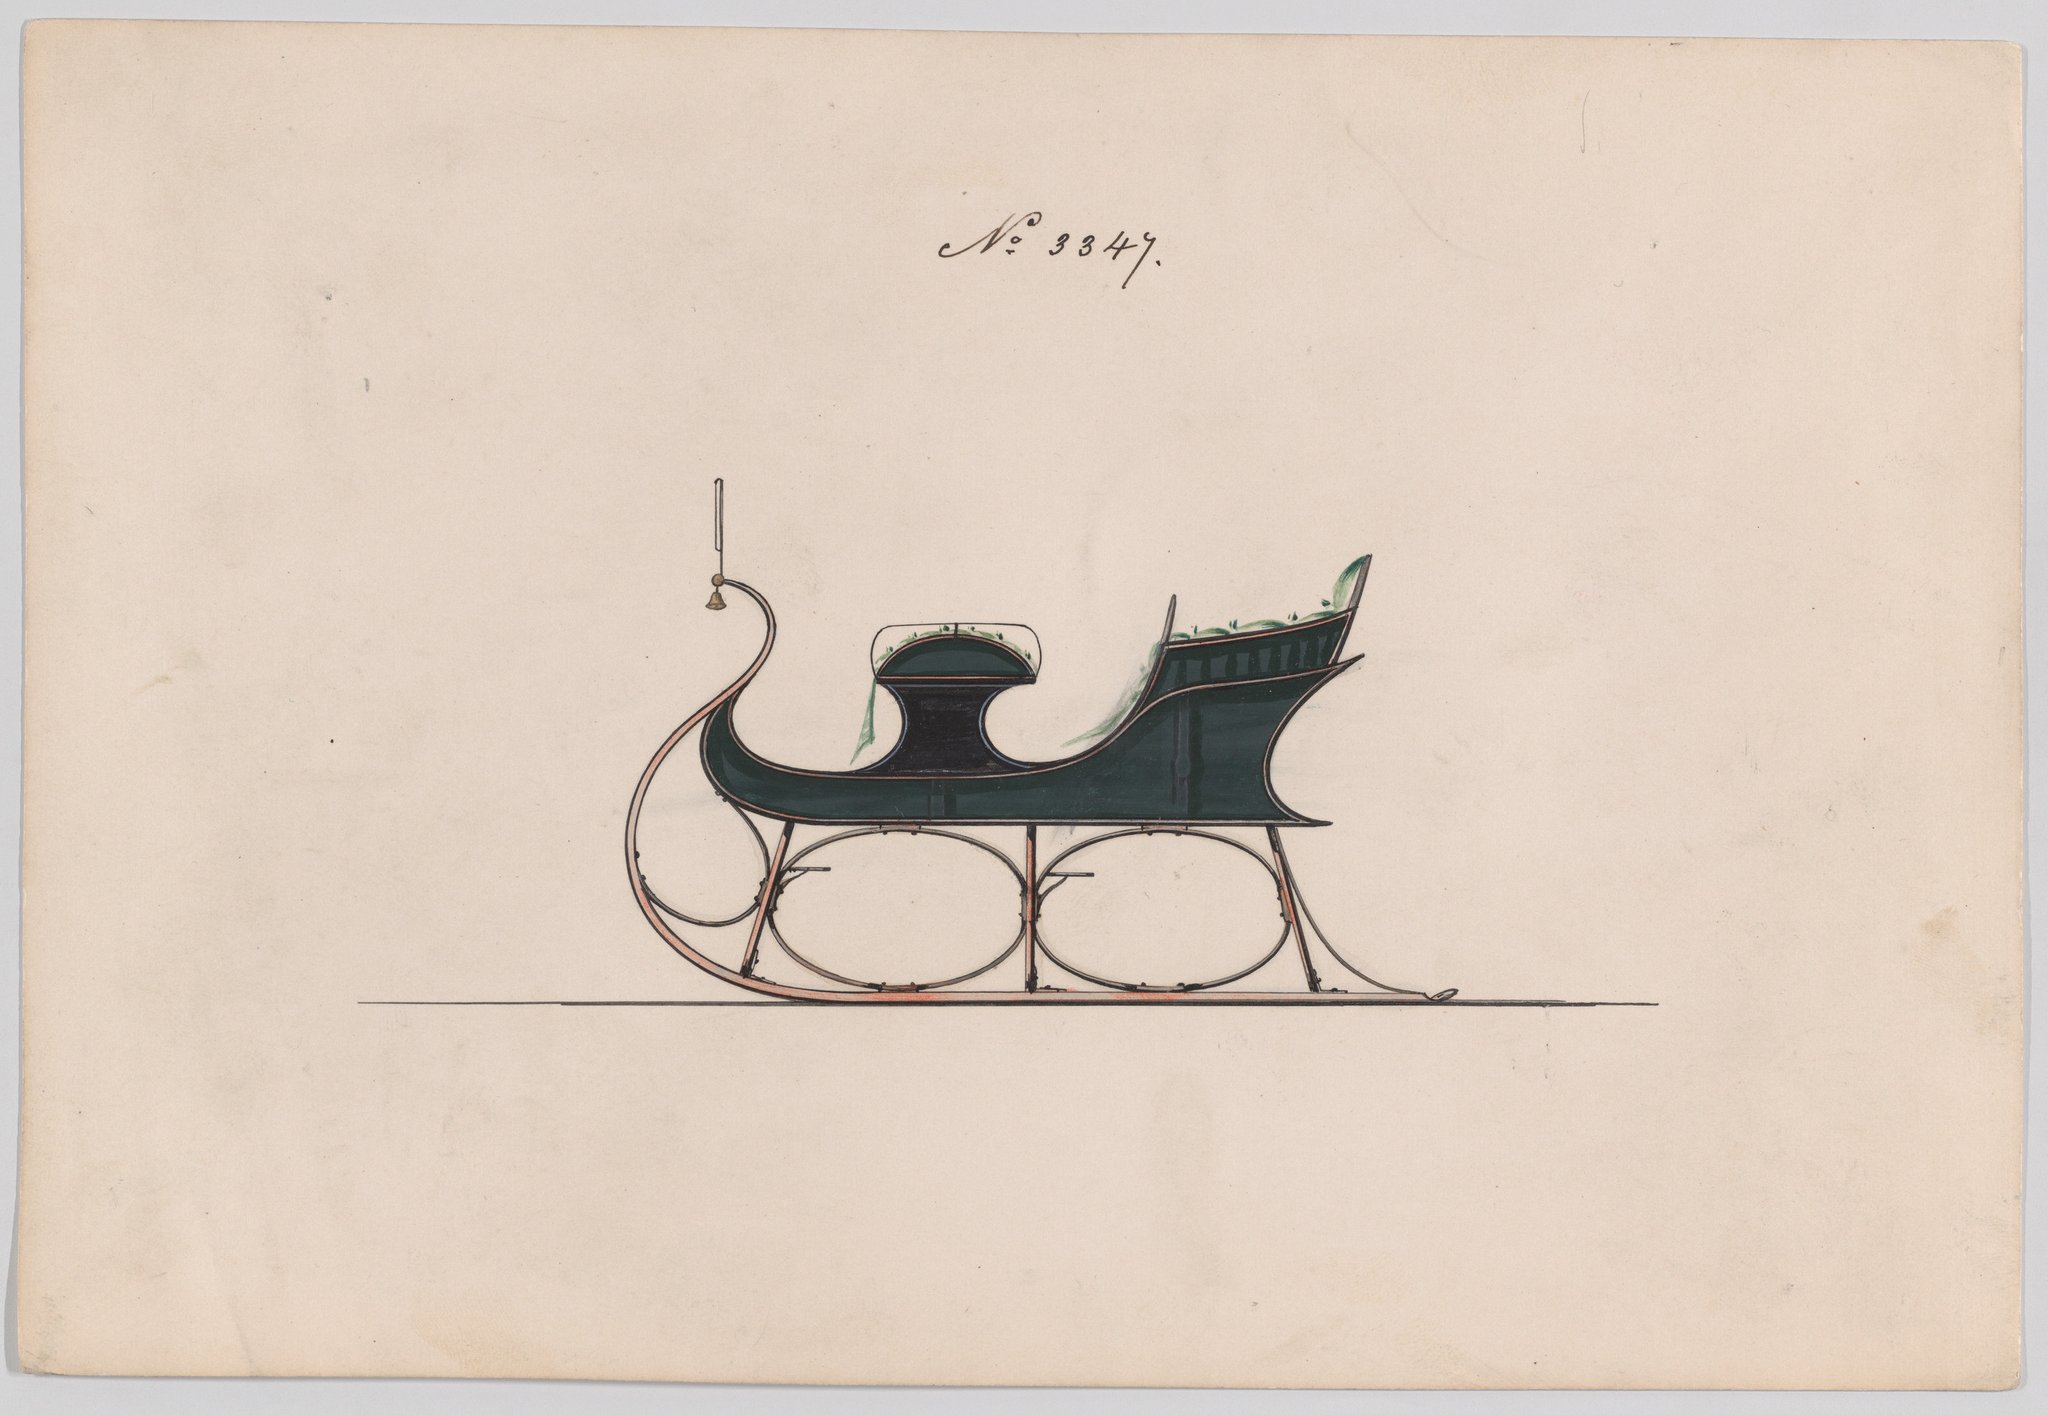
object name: drawing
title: Sleigh #3347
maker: brewster & co.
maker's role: manufacturer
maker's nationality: american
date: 1877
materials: ink, watercolor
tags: sleighs